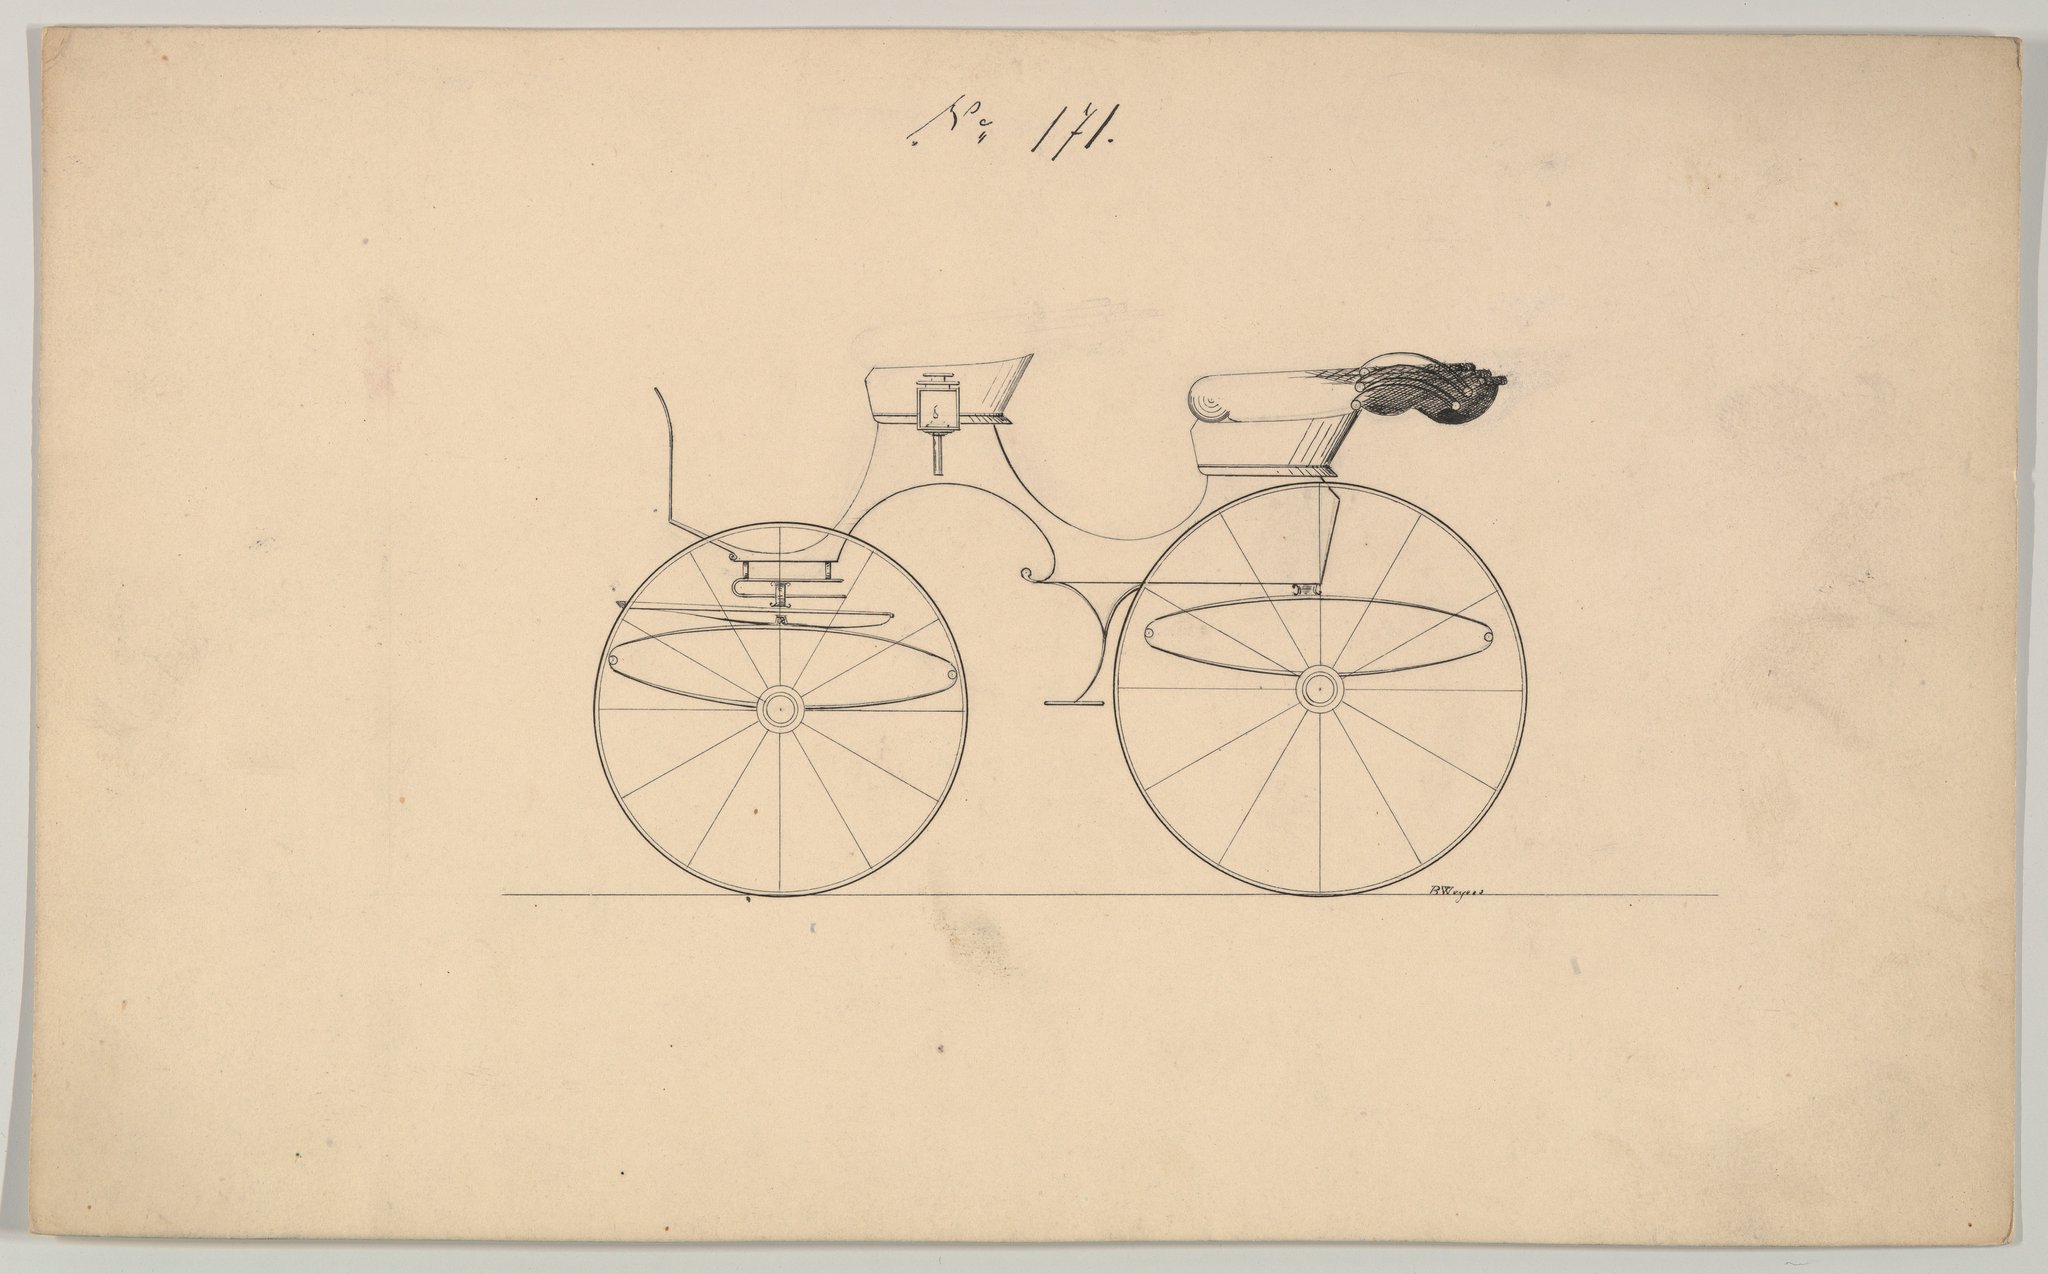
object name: drawing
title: Design for Phaeton, no. 171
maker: brewster & co.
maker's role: manufacturer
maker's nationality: american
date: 1850-1874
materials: ink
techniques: pen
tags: carriages